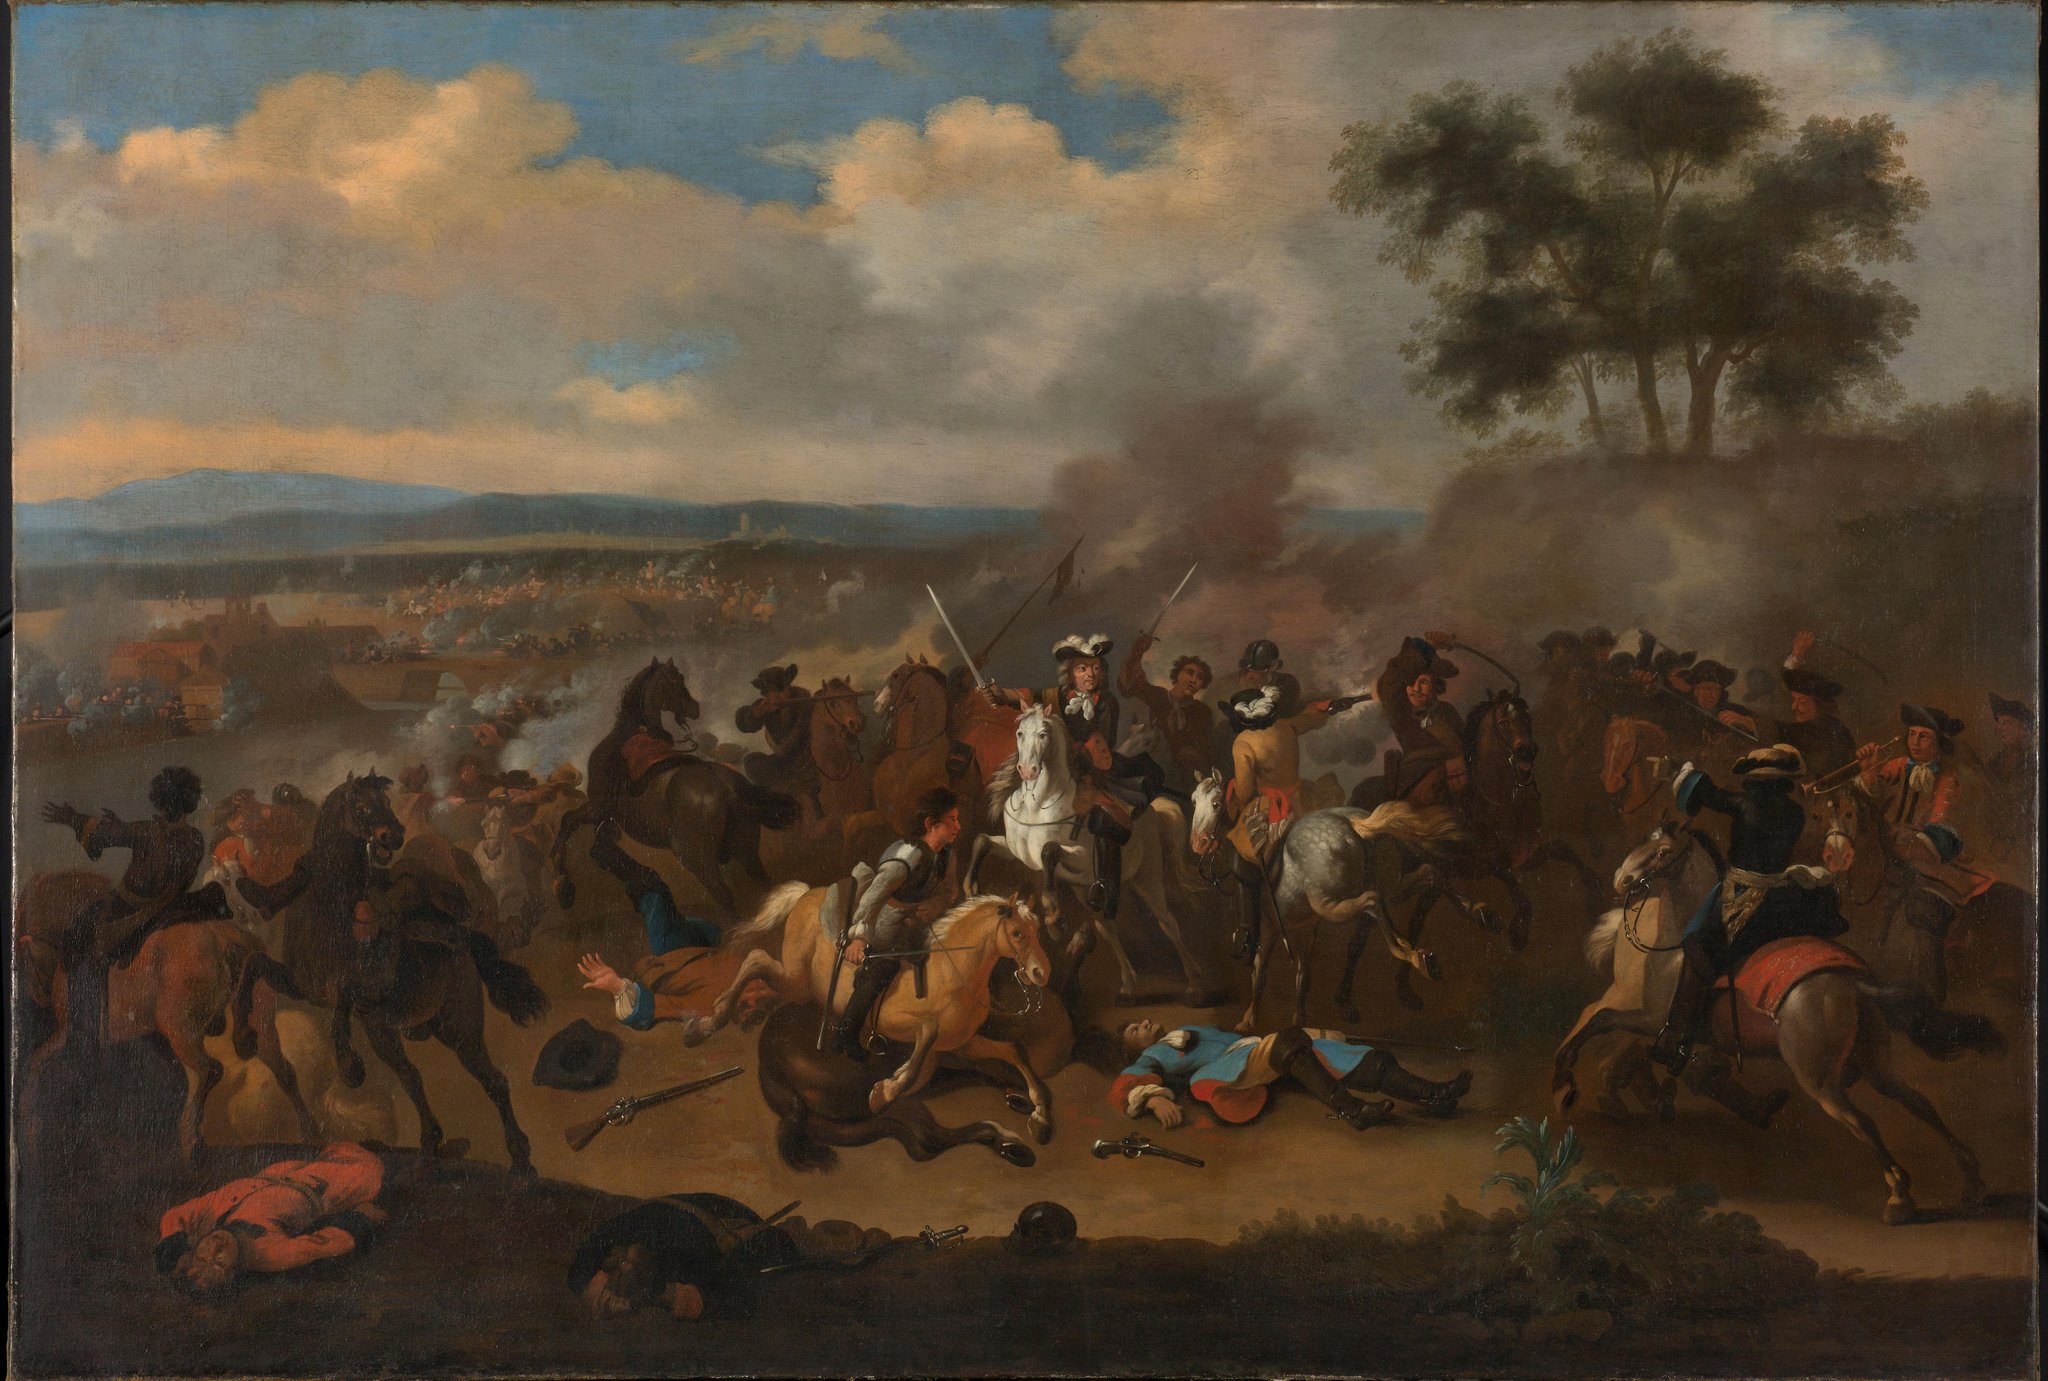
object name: painting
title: The Battle of the Boyne, Ireland, between Kings James II and William III, 12 July 1690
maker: jan van huchtenburg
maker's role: draughtsman, painter, print maker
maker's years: 1647-1733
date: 1690-1733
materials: canvas, oil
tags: jacobus ii (koning van engeland en schotland), the hague, william iii (prince of orange and king of england, scotland, and ireland), battle (+ land forces)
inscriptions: signature: ‘J. v. Hugtenburg F.’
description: Battle of the Boyne between James II and William III, 11 June 1690 by Johan van Huchtenburg When the English king James II fathered a Catholic heir, leading Protestants turned in desperation to Prince William III for aid. The Dutch Protestant stadholder was James's son-in-law. Fearing an alliance between the Catholic French and English monarchs William's response was positive. In 1688 he gathered an army and crossed over to England. Deposed, James II continued the fight with French aid in Ireland, only to be defeated in 1690 at the Battle of the Boyne. Left: the hard-fought bridge over the Boyne in Drogheda. Perhaps the horseman in the centre (on the white horse) is William III.